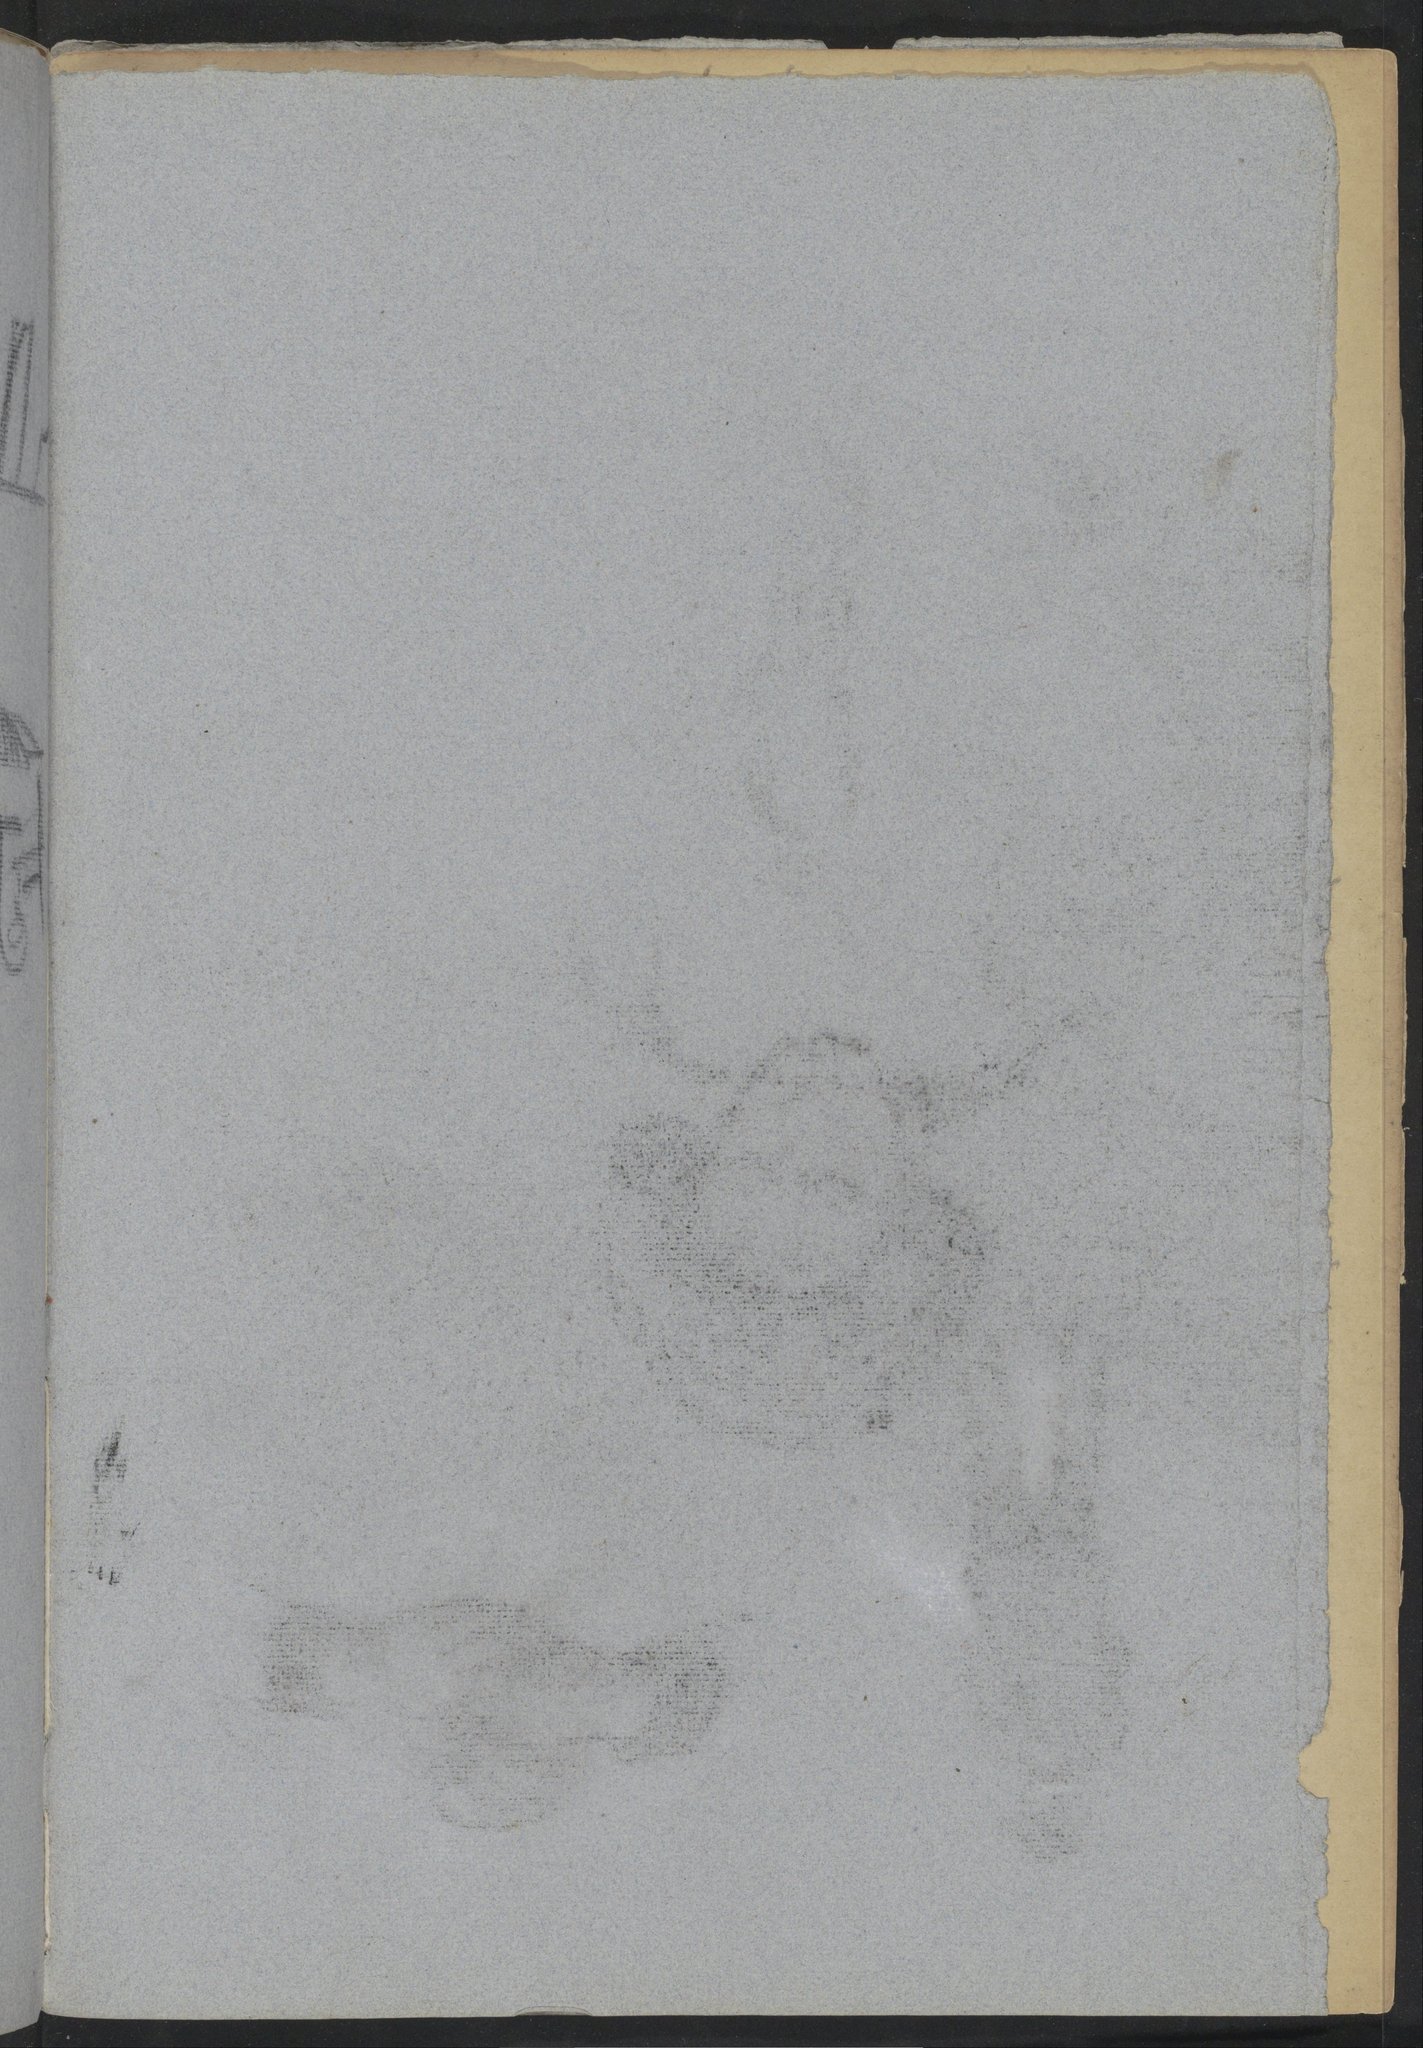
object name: sketchbook leaf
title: Abklatsch van een krijttekening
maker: jan veth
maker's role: designer, draughtsman, painter, print maker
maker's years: 1864-1925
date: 1874-1925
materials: paper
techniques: printmaking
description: Studies van een vrouwenkop, een man op de rug gezien en handen die niet langer in het schetsboek aanwezig zijn. Blad 36 recto uit een schetsboek met 42 bladen.